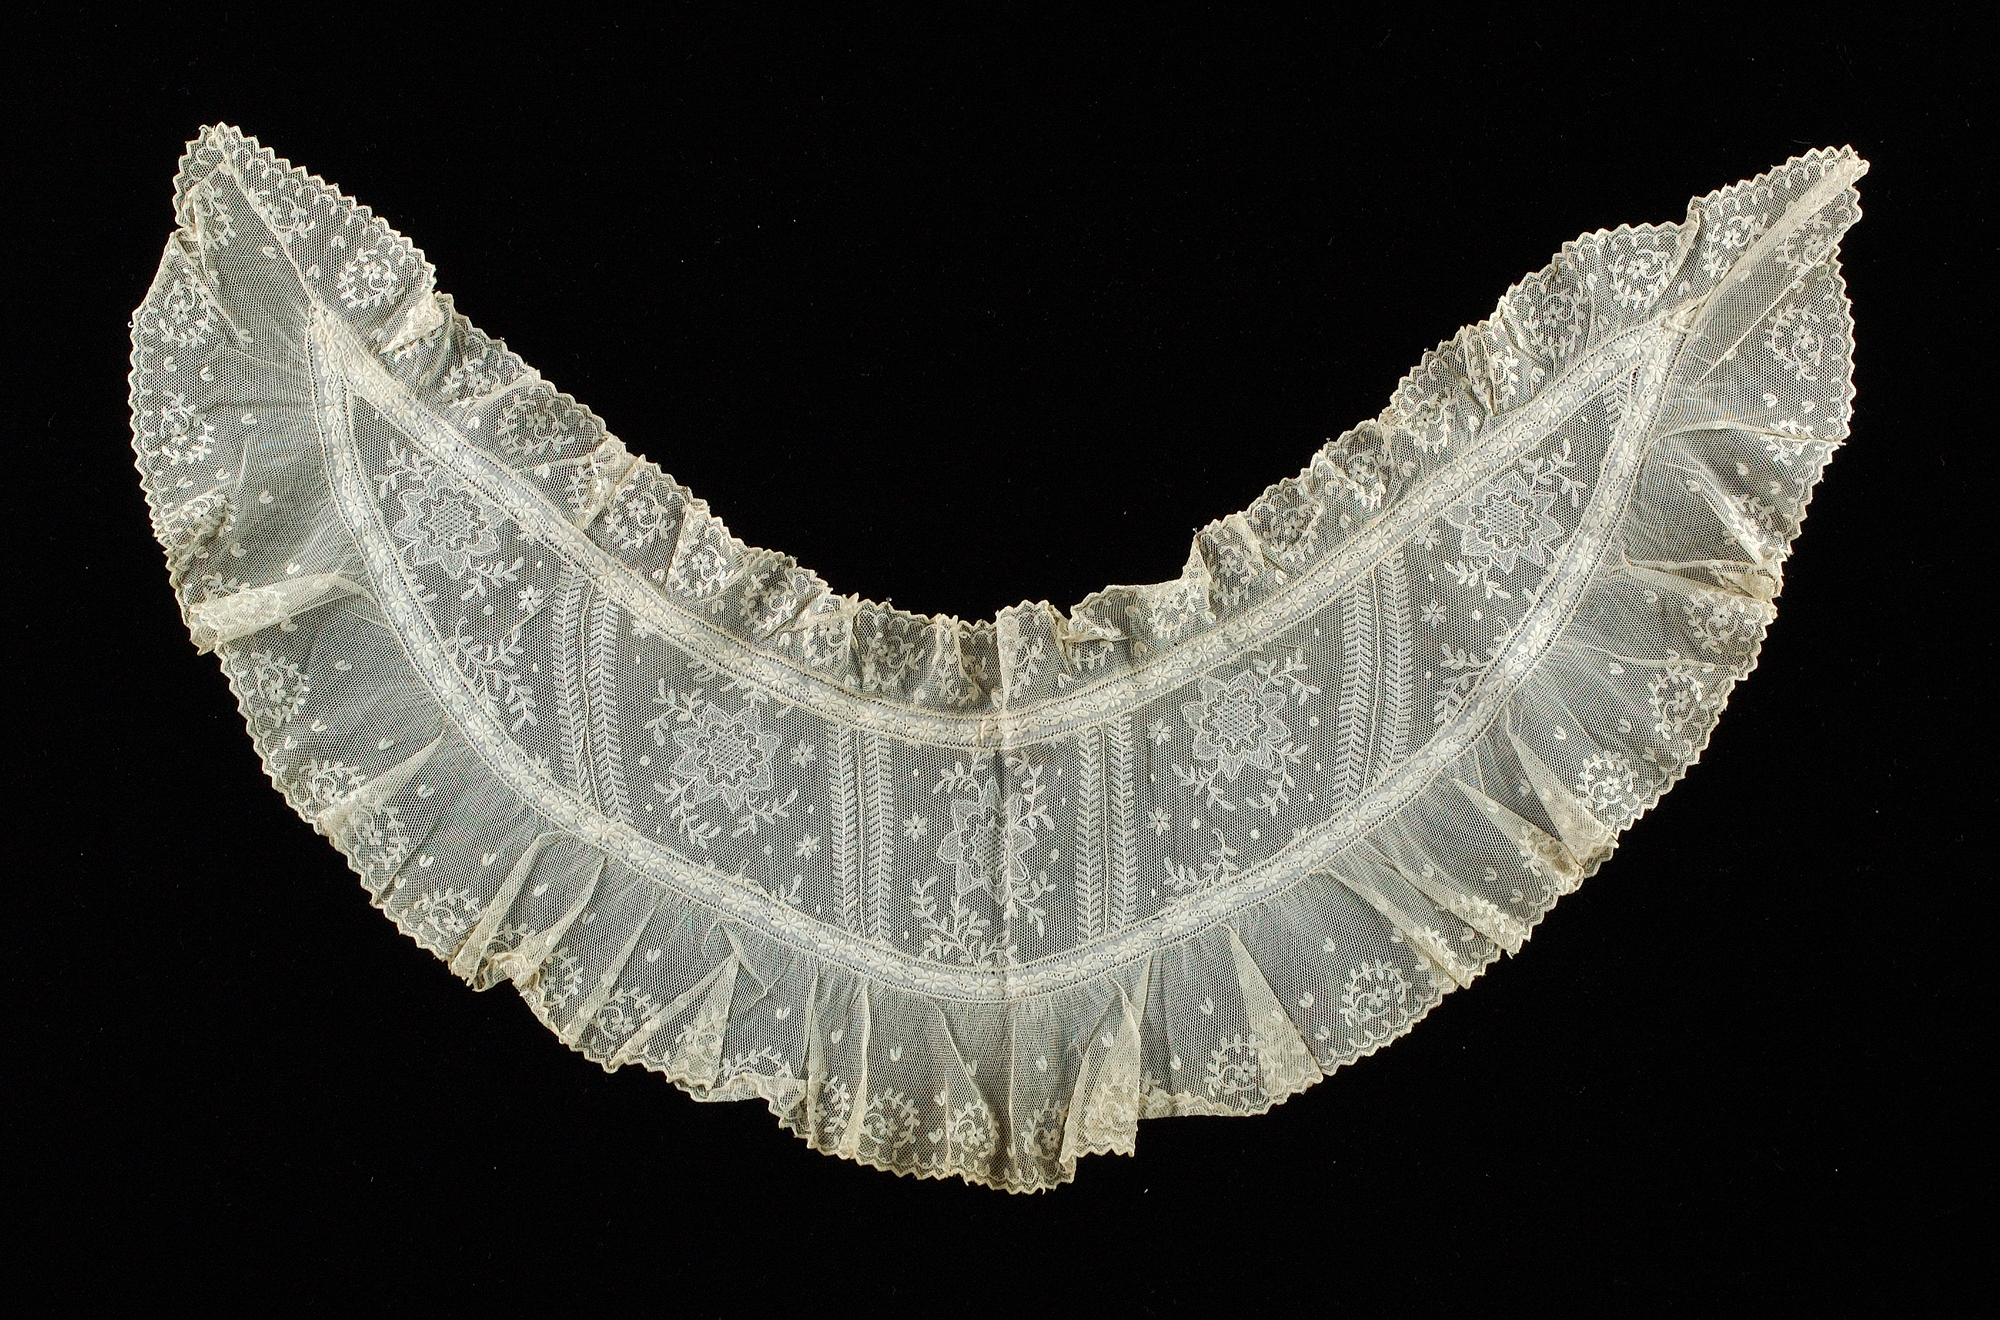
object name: collar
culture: british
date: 1851-1875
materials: cotton, silk